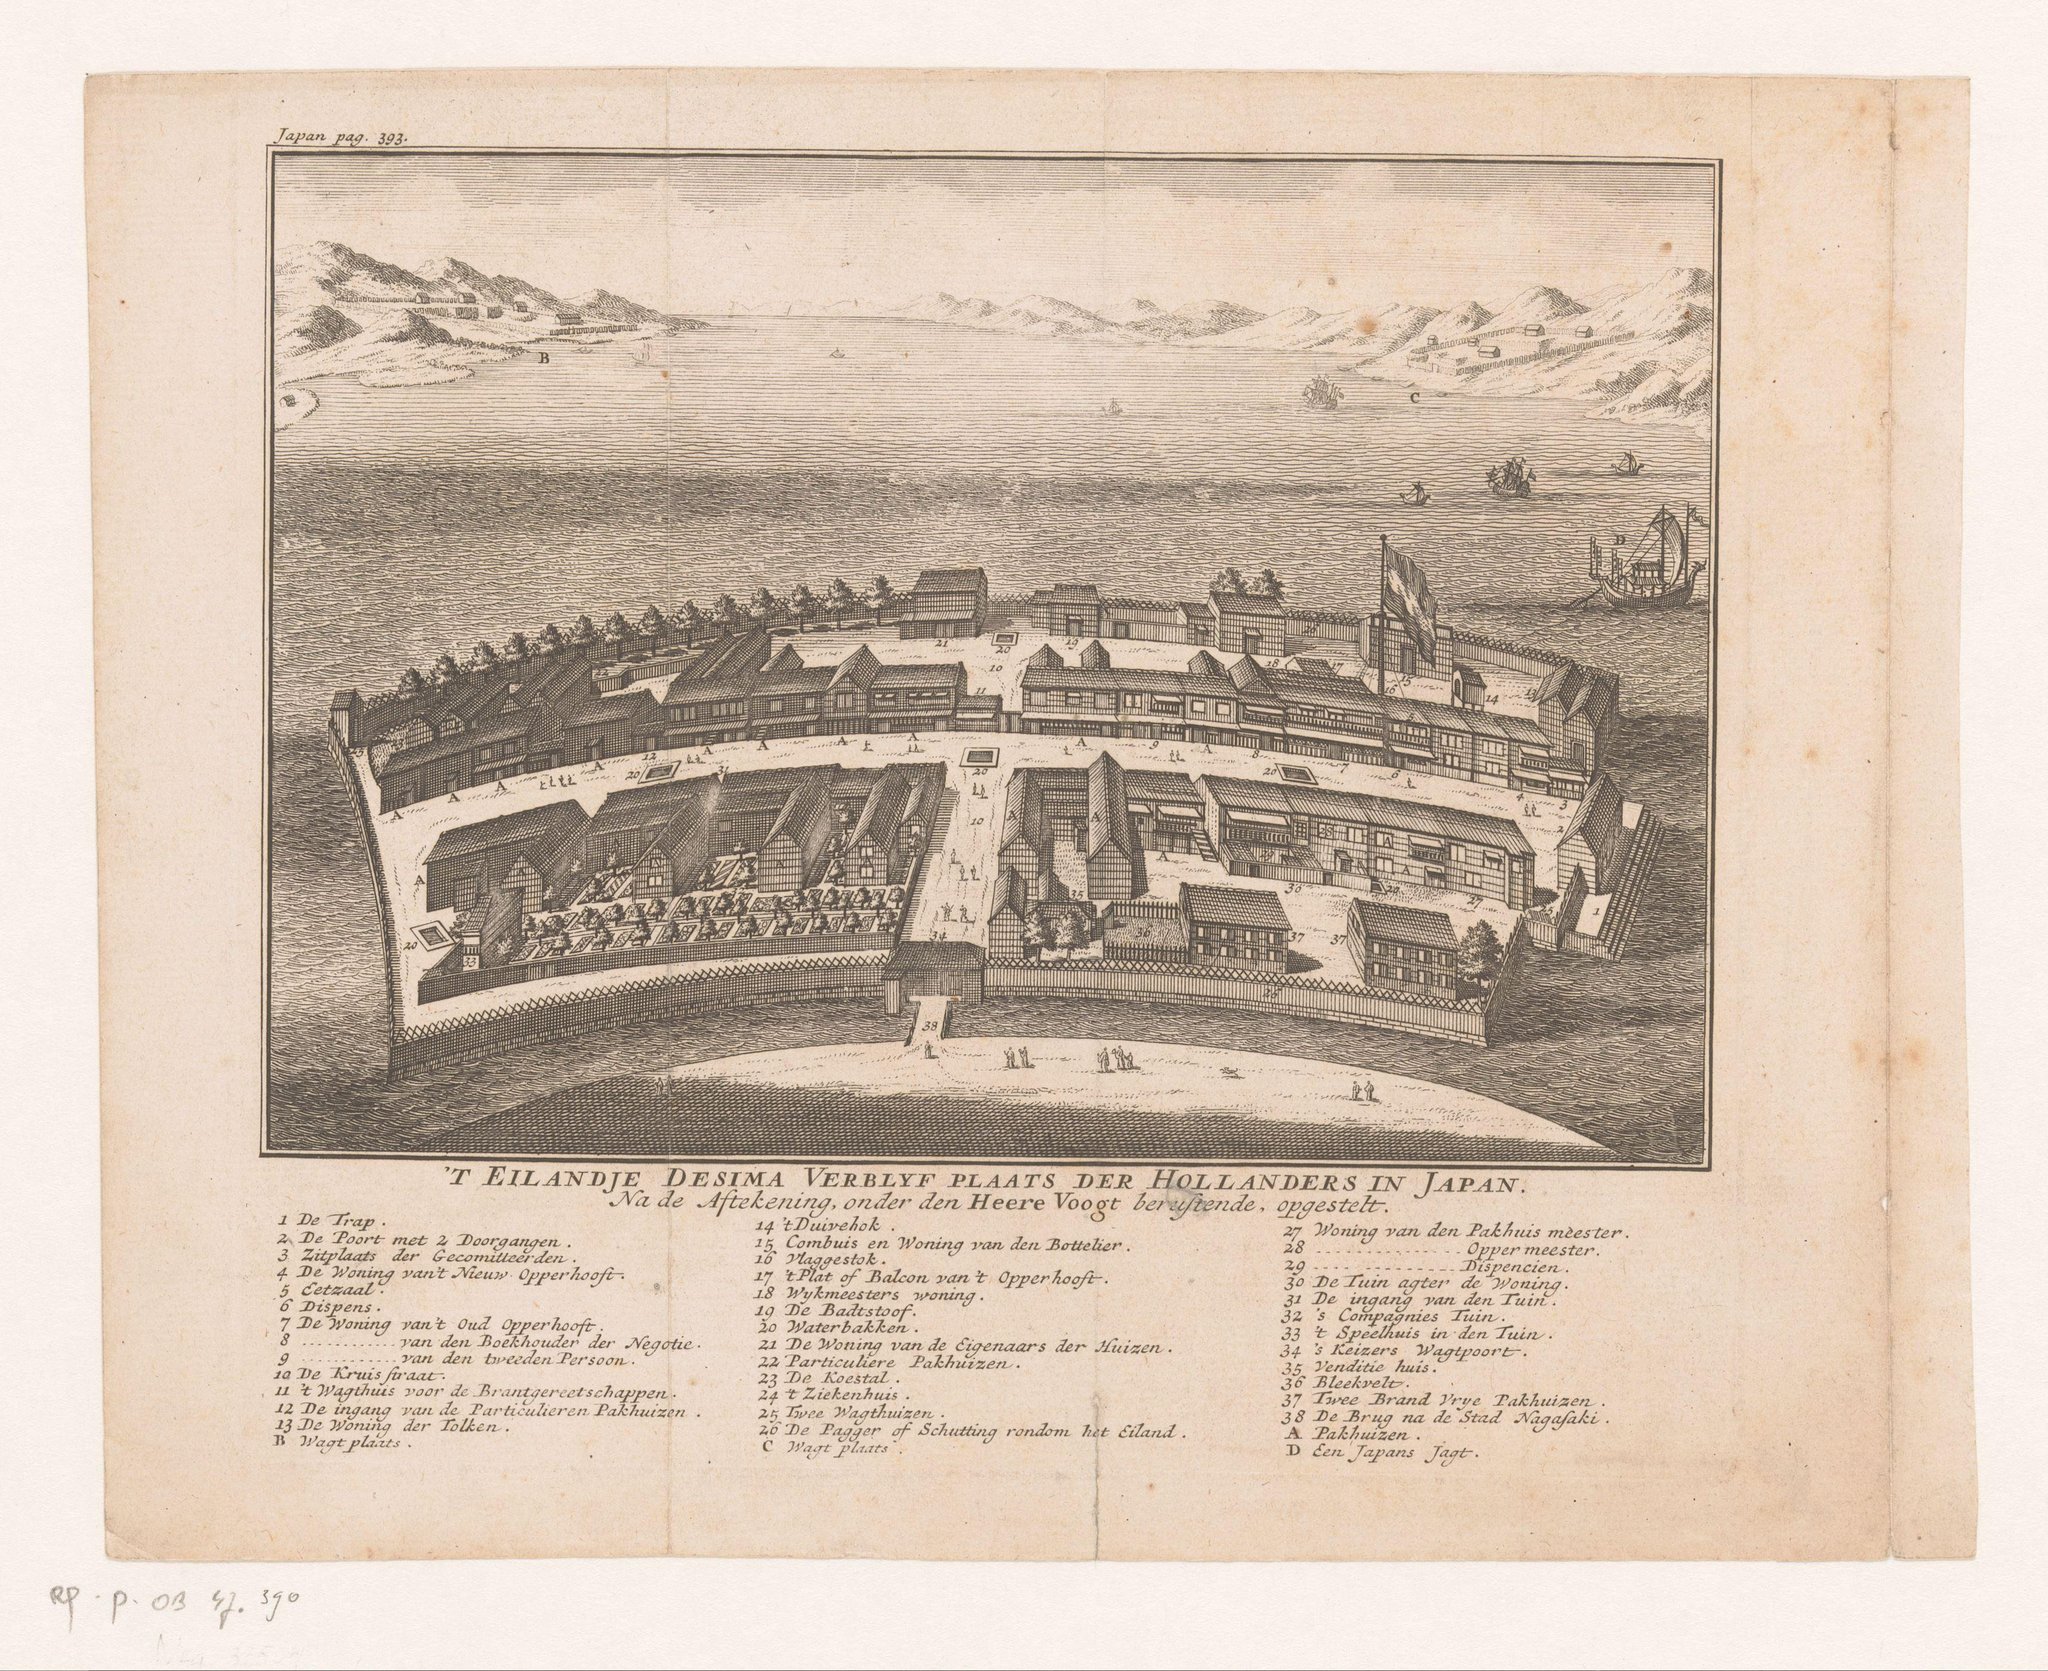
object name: book illustration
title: 't Eilandje Desima verblyf plaats der Hollanders in Japan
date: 1729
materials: paper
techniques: engraving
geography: amsterdam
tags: maps of cities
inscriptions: collector's mark: Lugt 2228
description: uit: Salmon, Th. Hedendaegsche historie, of tegenwoordige staat (...), 22 dln. Amsterdam: Isaak Tirion, 1729-1772, dl. 1, p. 393.